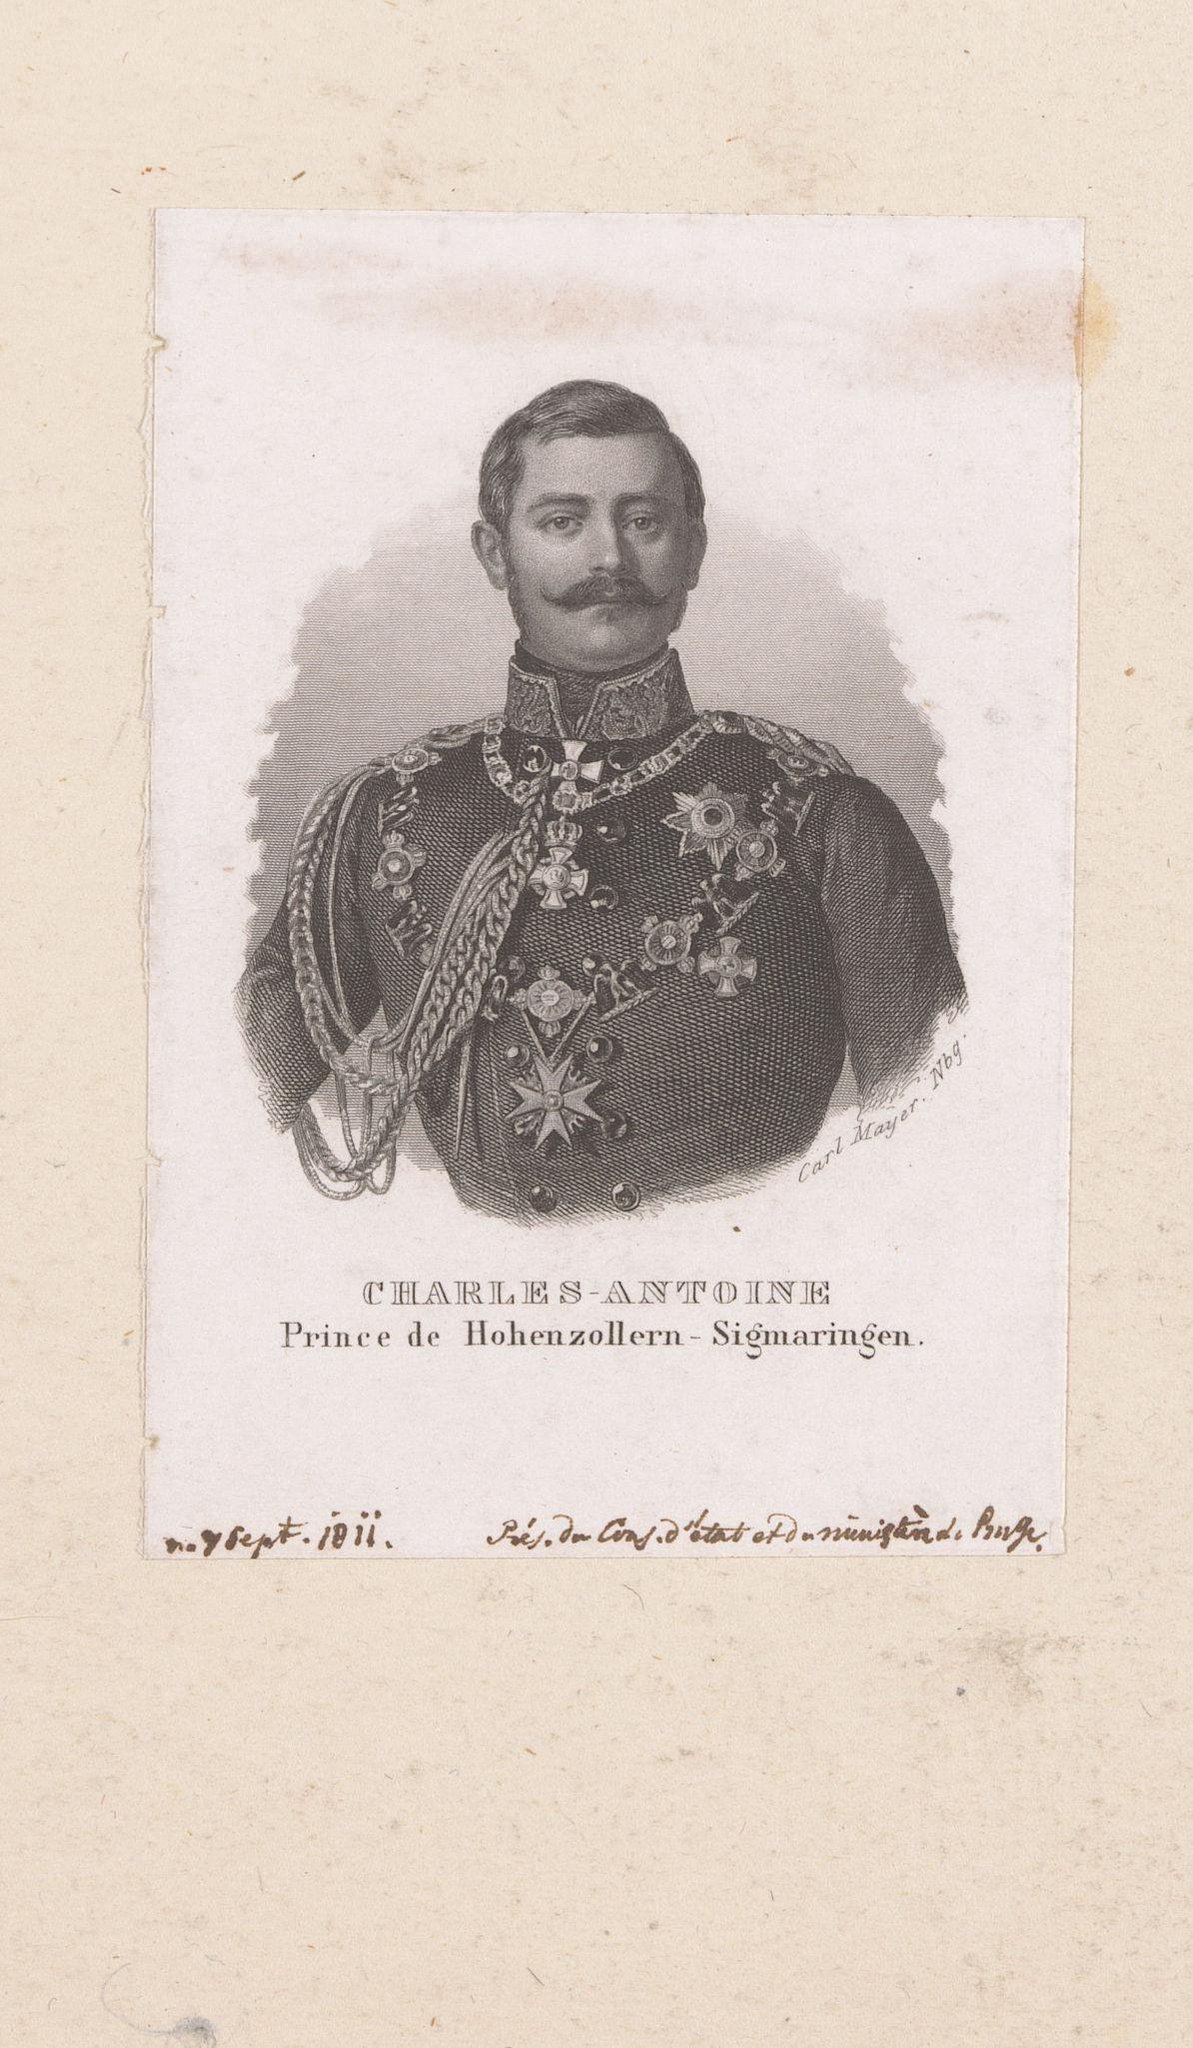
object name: print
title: Portret van Karel Anton van Hohenzollern-Sigmaringen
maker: carl mayer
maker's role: print maker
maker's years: 1798-1868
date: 1811-1868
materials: paper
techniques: engraving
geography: nuremberg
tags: historical persons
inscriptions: collector's mark: Lugt 2228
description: Vermoedelijk afkomstig uit: Almanach de Gotha.